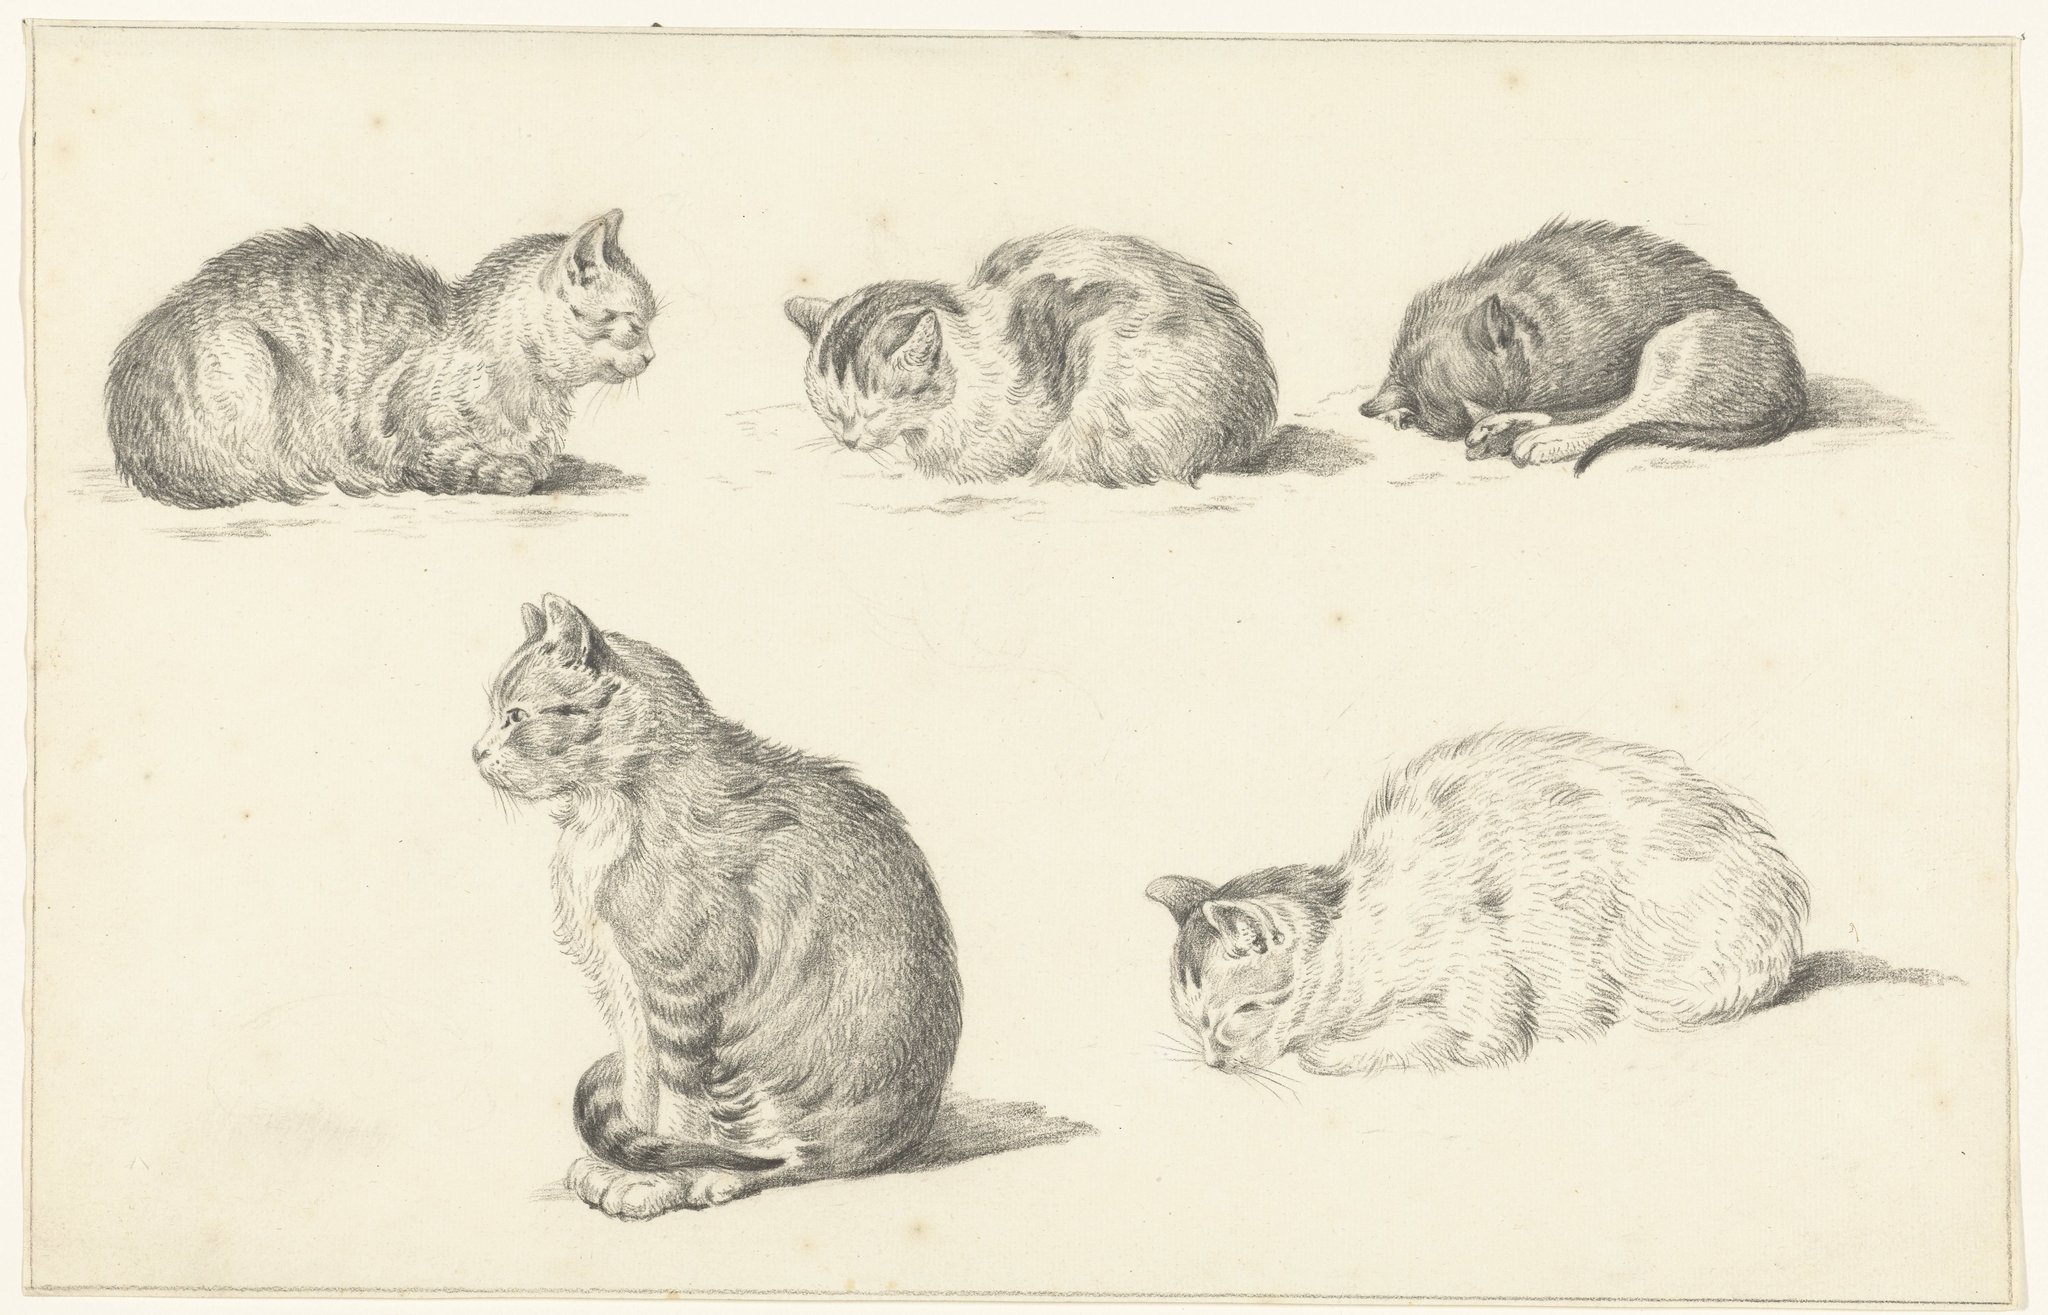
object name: drawing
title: Fives Studies of Cats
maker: jean bernard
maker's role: draughtsman, print maker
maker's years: 1765-1833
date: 1812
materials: chalk, paper, pencil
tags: cat